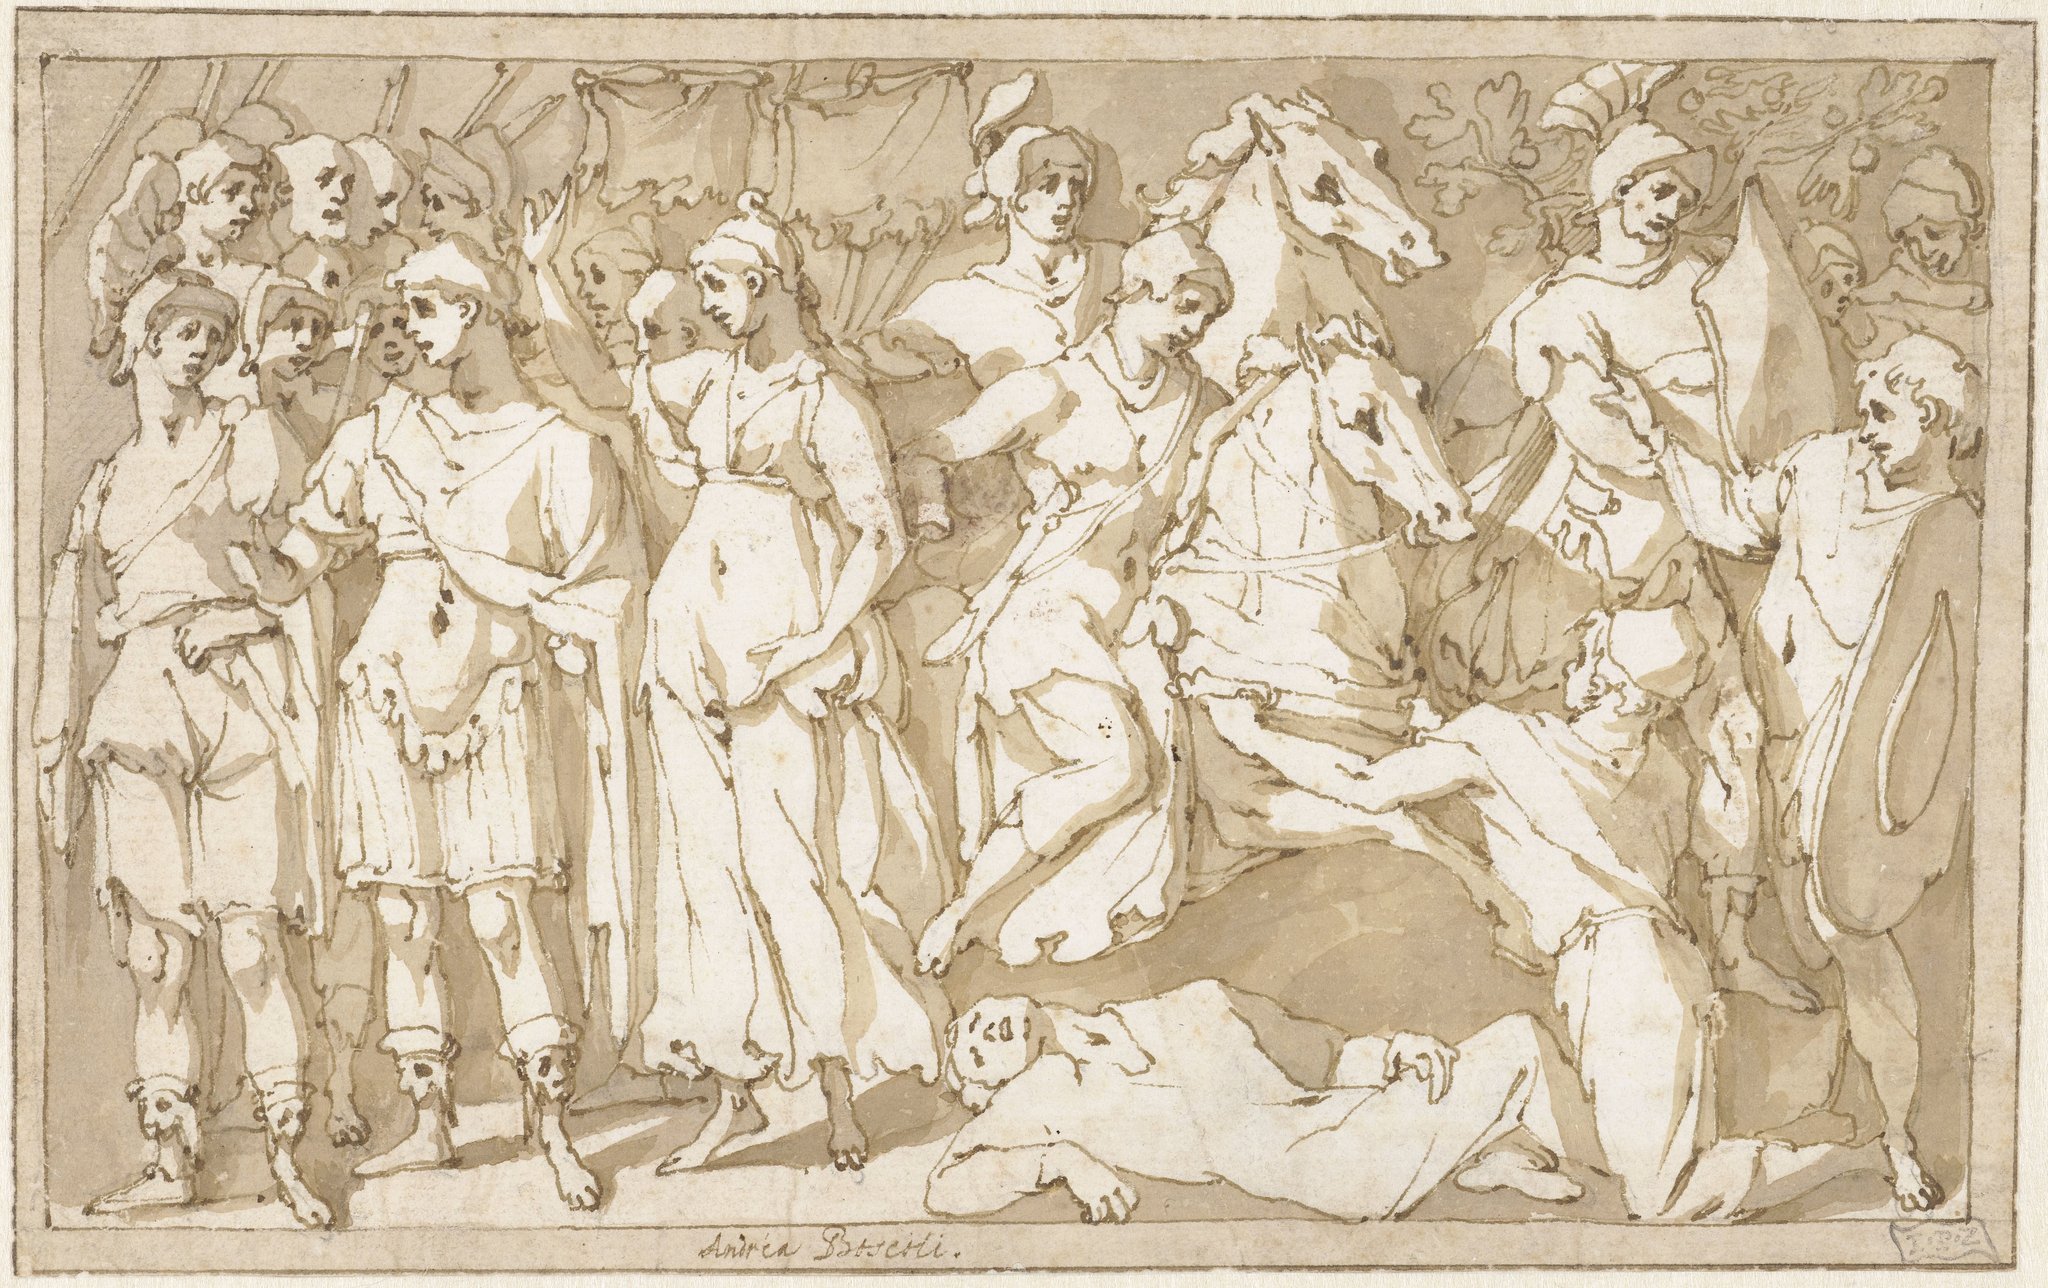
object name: drawing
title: Keizer Trajanus tussen Roma en Victoria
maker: andrea boscoli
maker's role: draughtsman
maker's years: 1560-1607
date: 1570-1607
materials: chalk, ink, paper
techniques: brush, pen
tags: keizer, trajanus (keizer van het romeinse rijk)